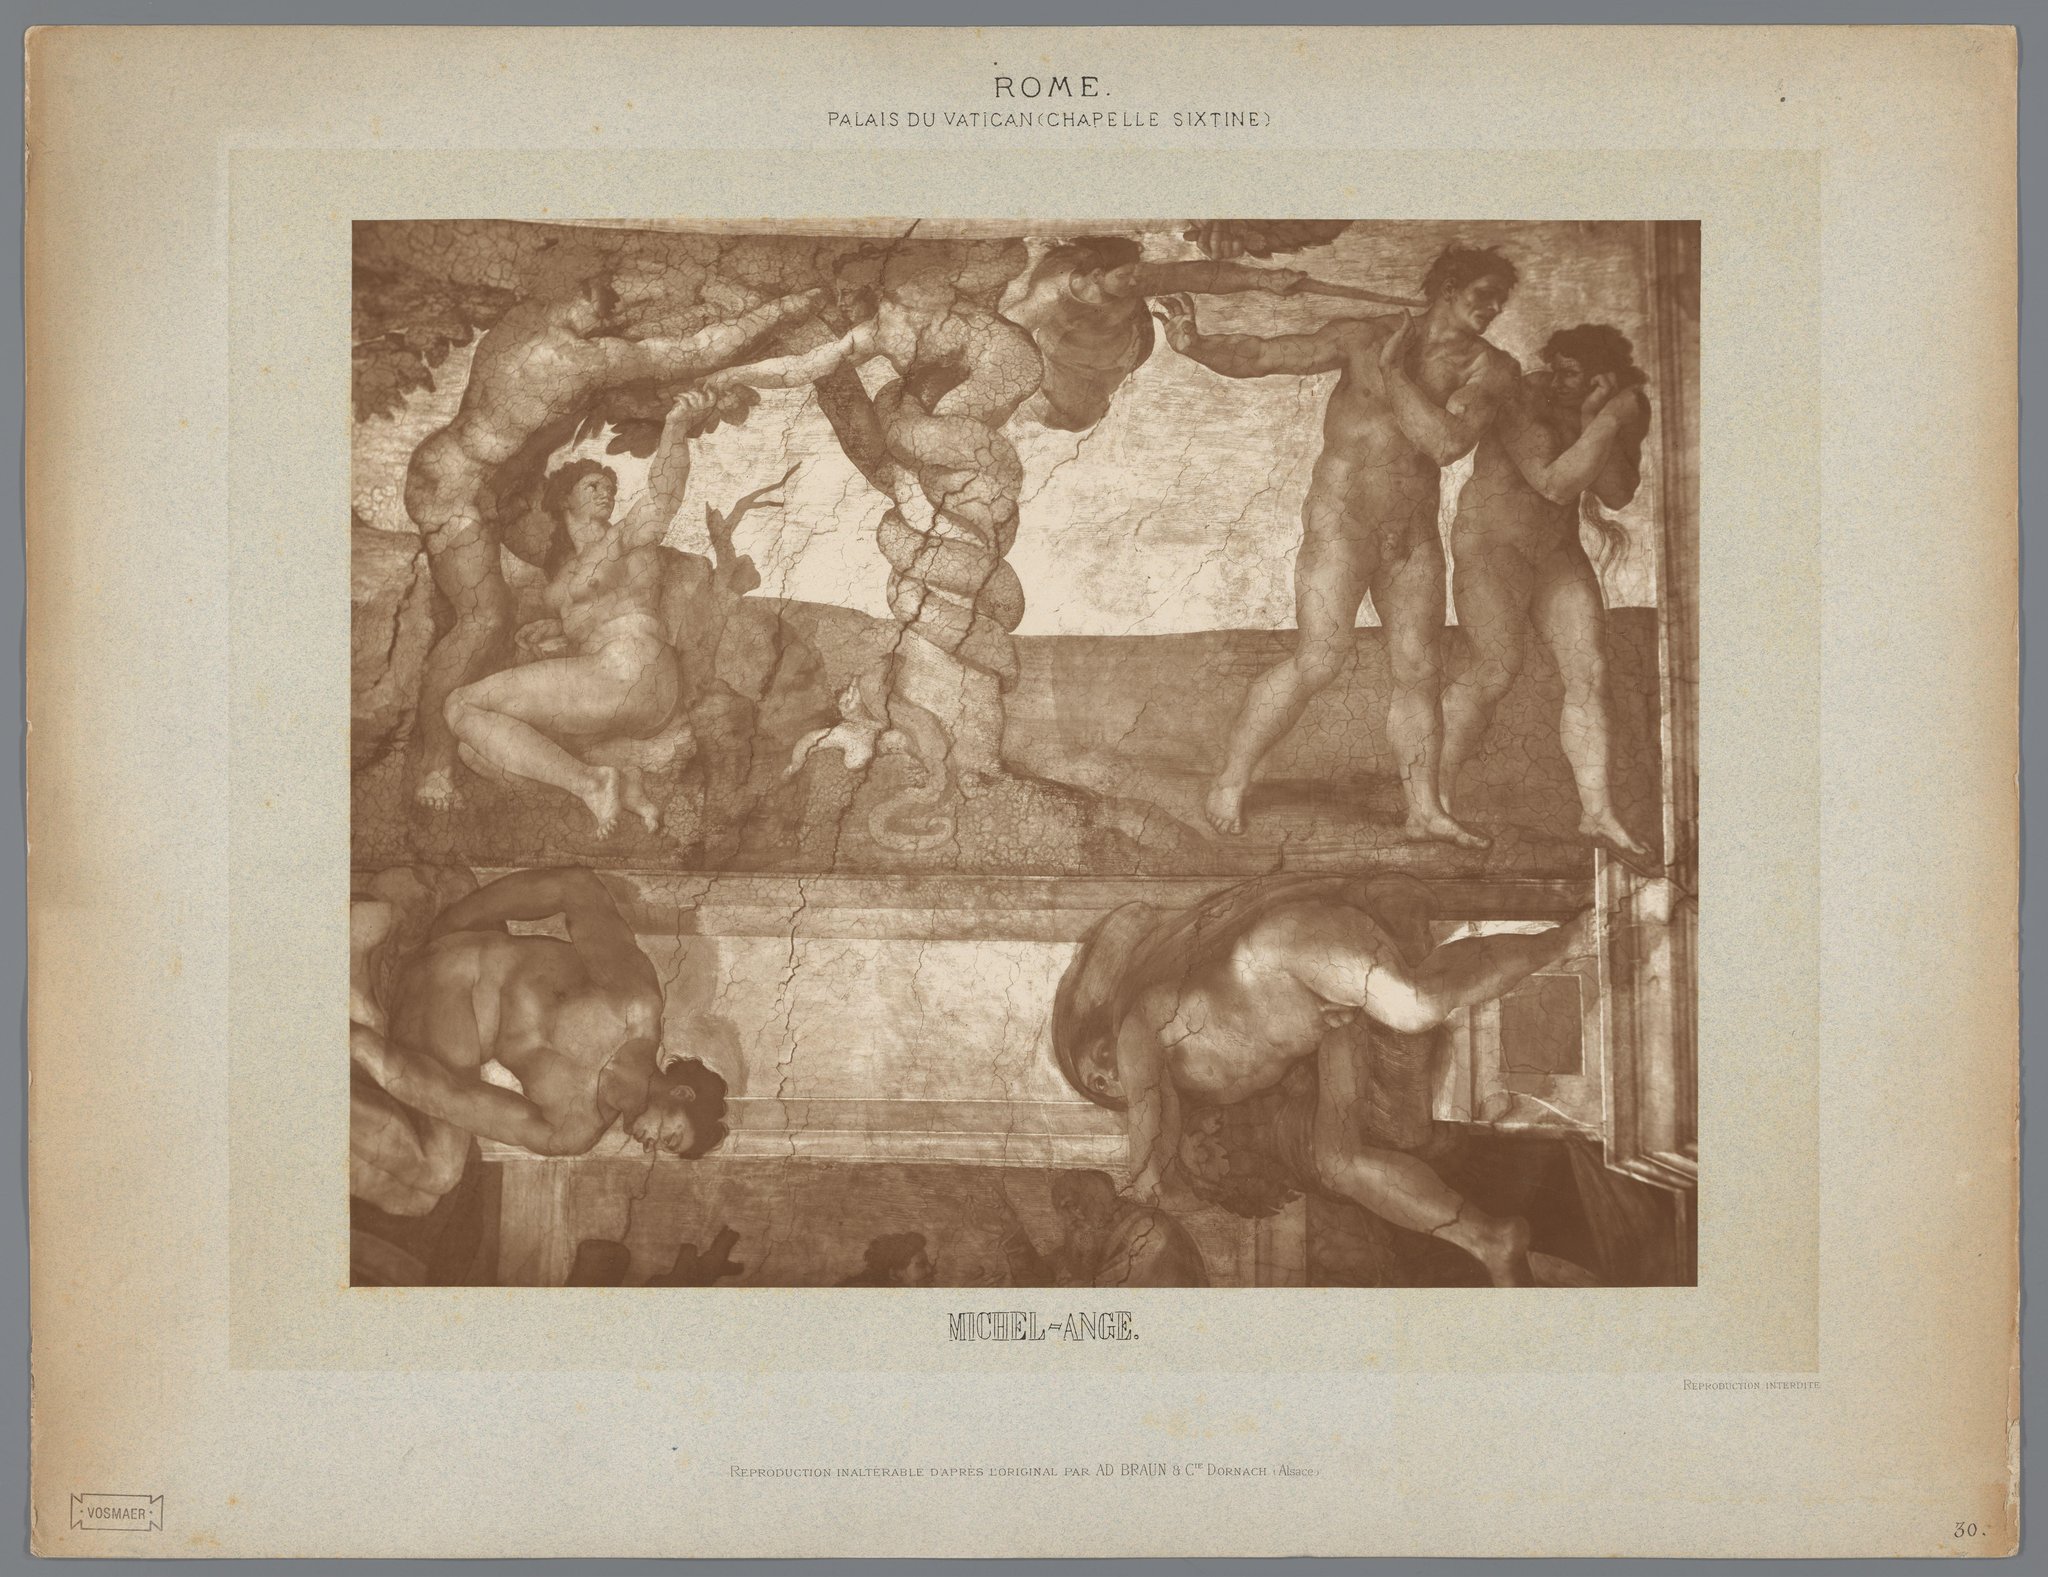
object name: photograph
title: Expulsion from Paradise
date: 1880-1900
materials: cardboard, paper, photographic support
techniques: carbon print